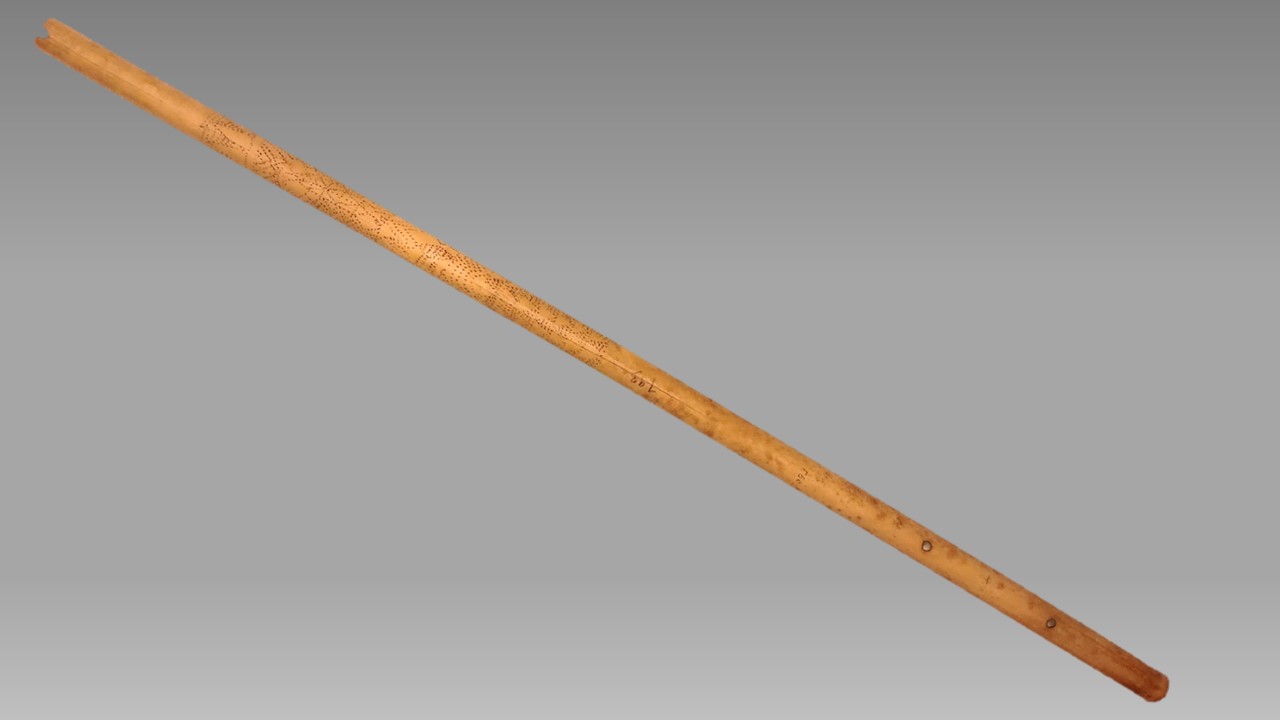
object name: gore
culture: melanesian, aoba island or vanuatuan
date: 1867-1900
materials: bamboo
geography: vanuatu